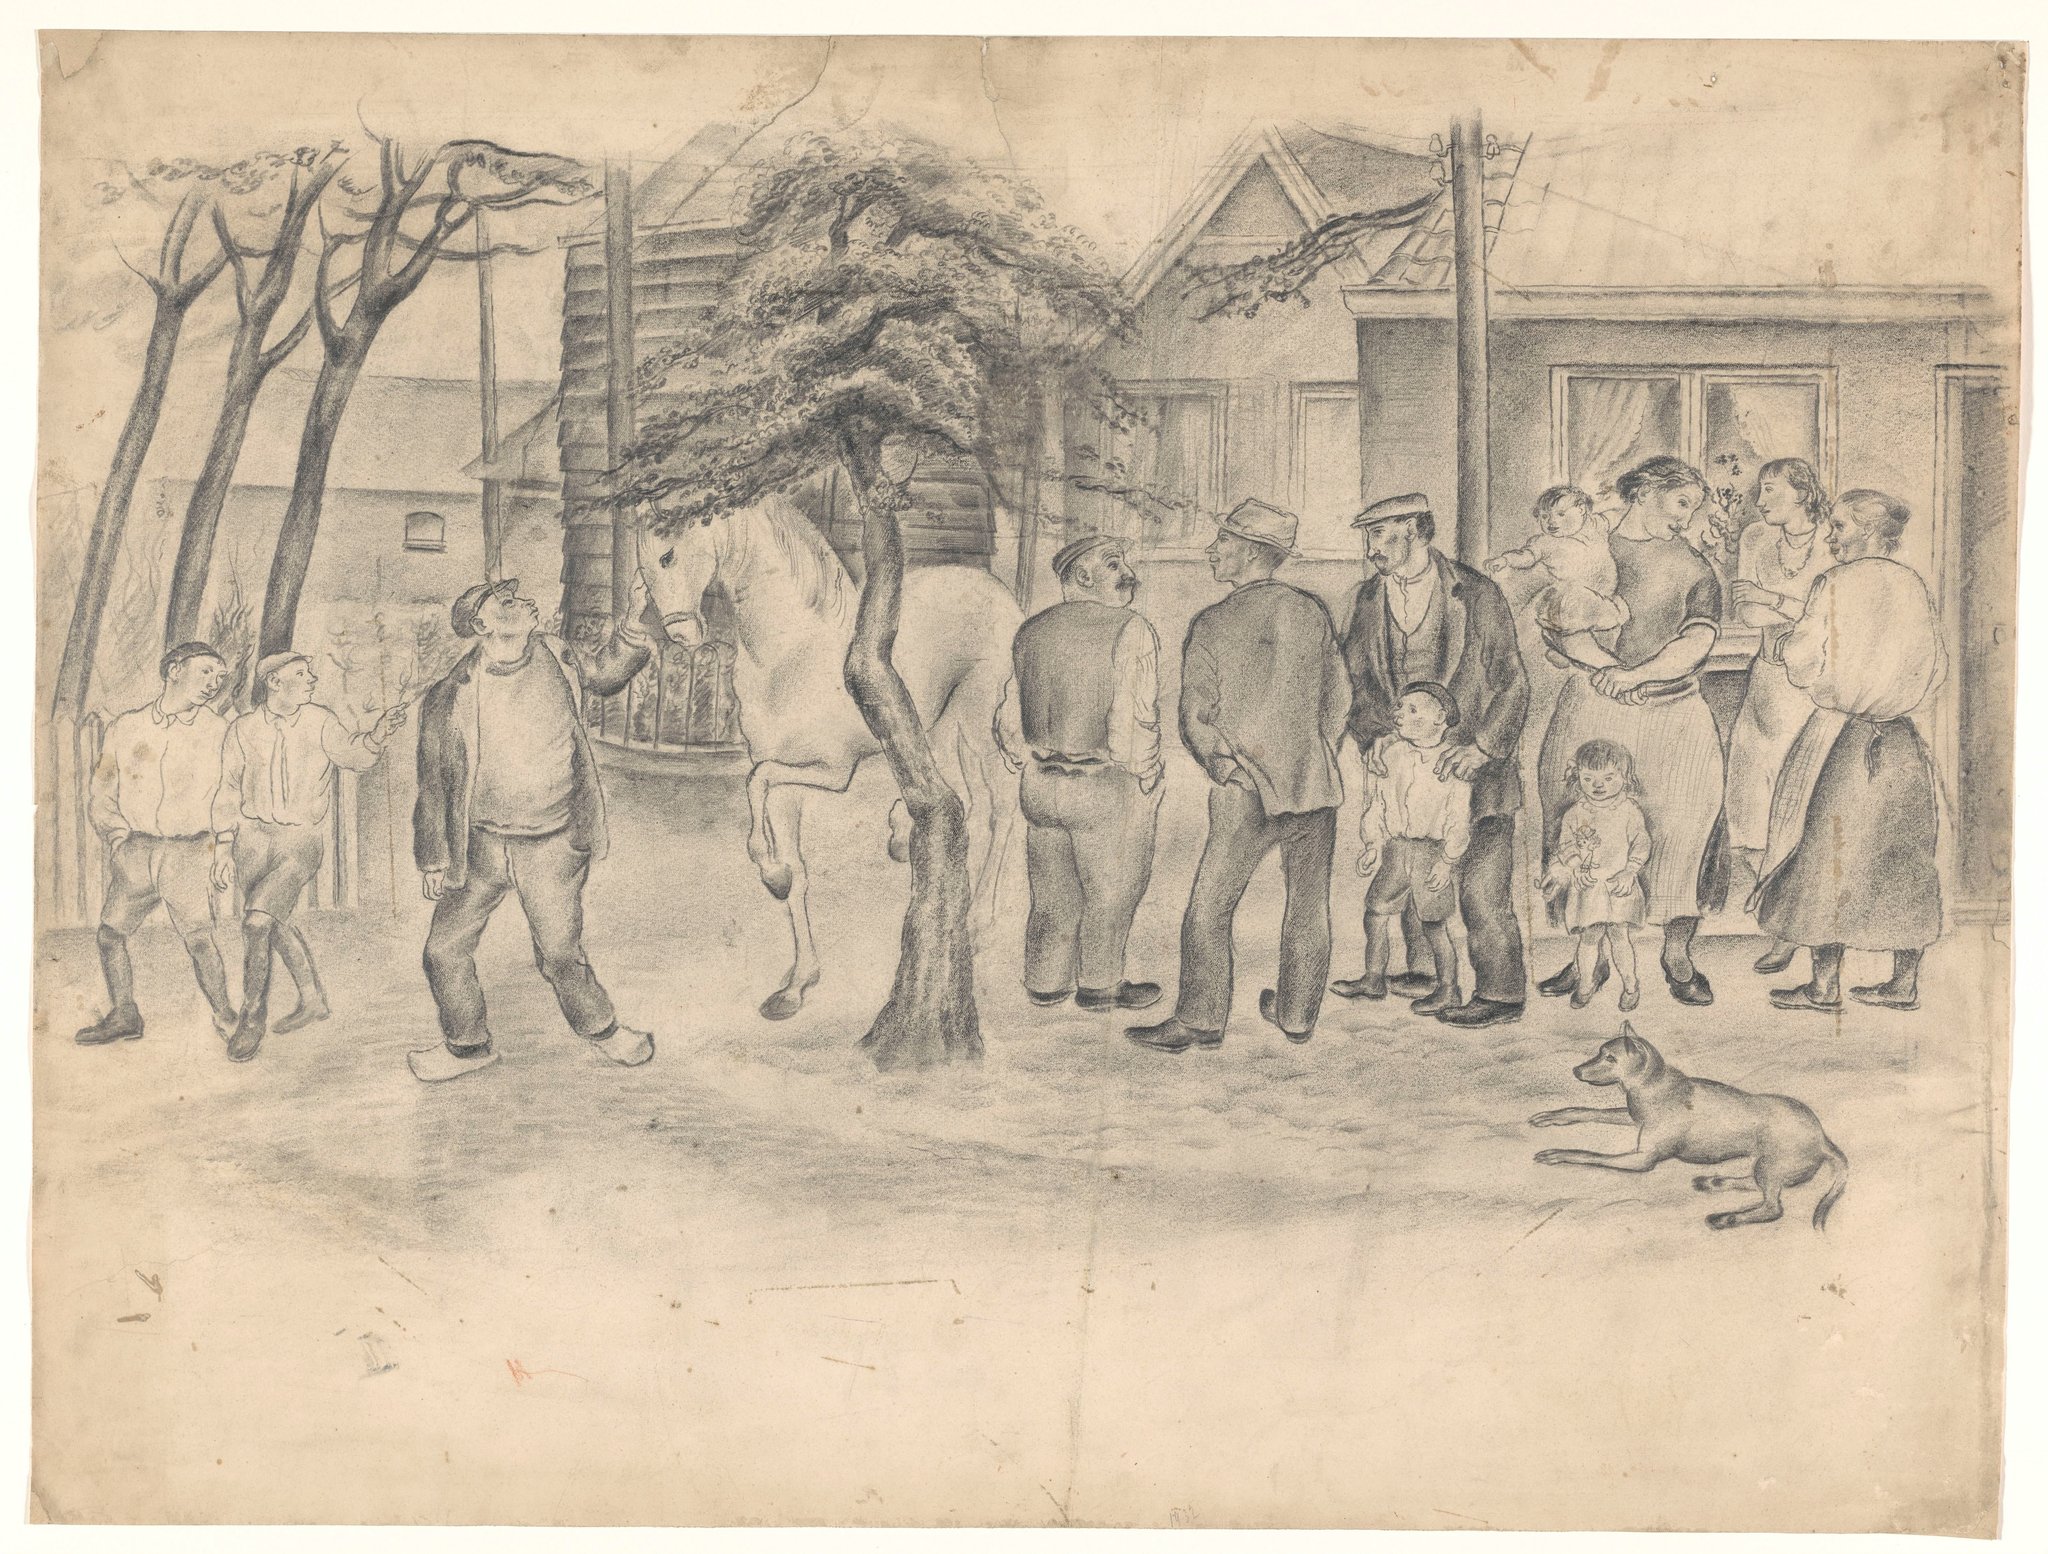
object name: drawing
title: Mannen, vrouwen en kinderen voor een boerderij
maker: henk henriët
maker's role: draughtsman, print maker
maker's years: 1903-1945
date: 1932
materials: paper, pencil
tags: parents with their children, horse, farm (building)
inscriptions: collector's mark: Lugt 2228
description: Links een man op klompen bij een paard en twee jongens.